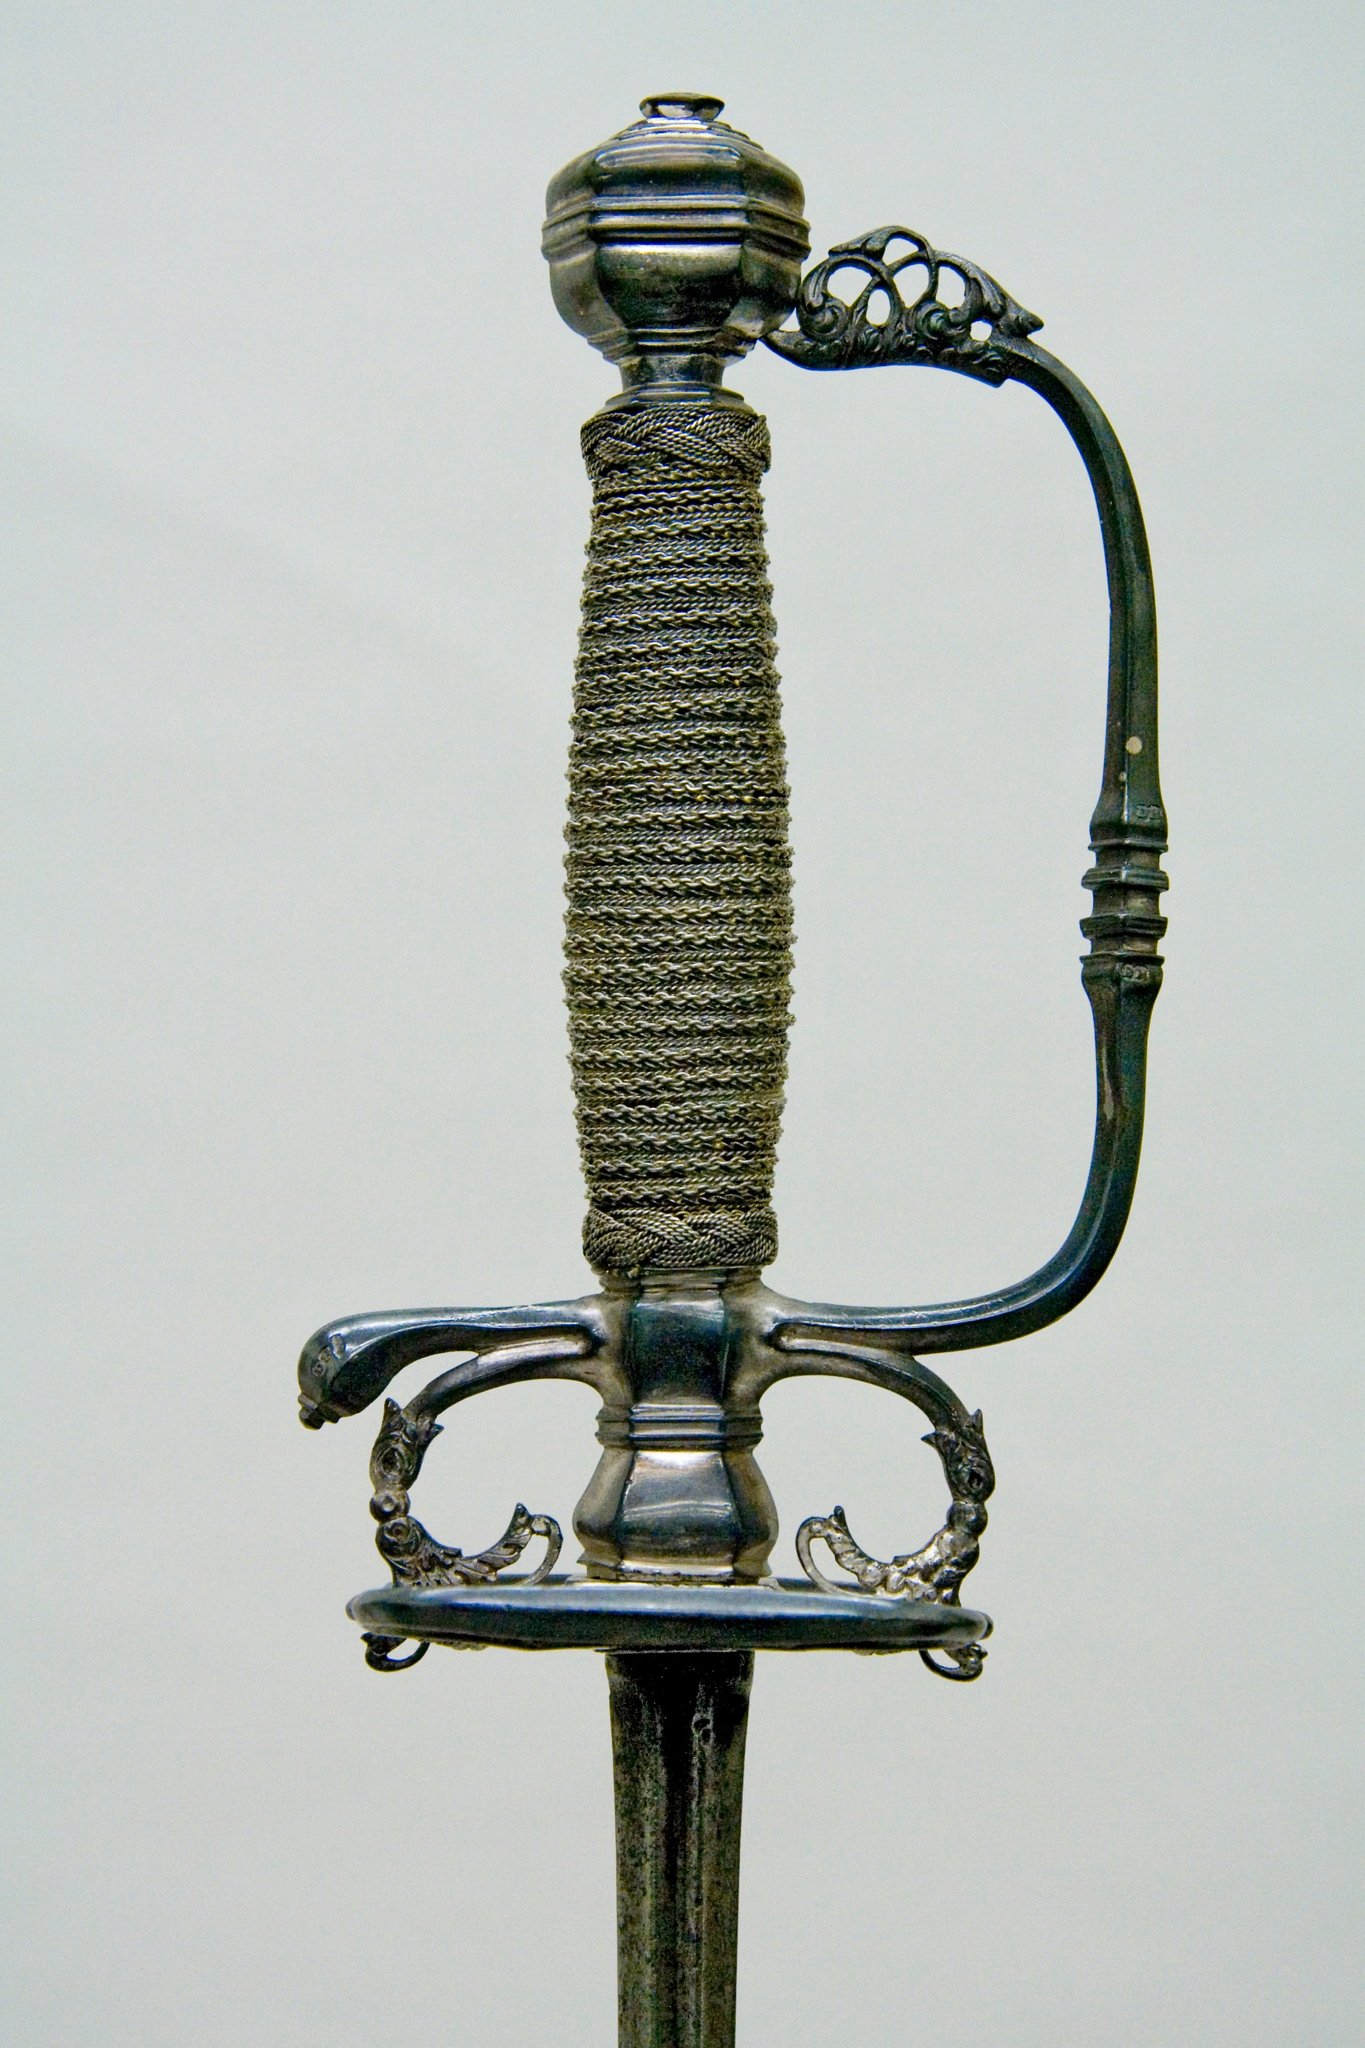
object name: smallsword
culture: british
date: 1700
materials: silver, steel, wood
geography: england